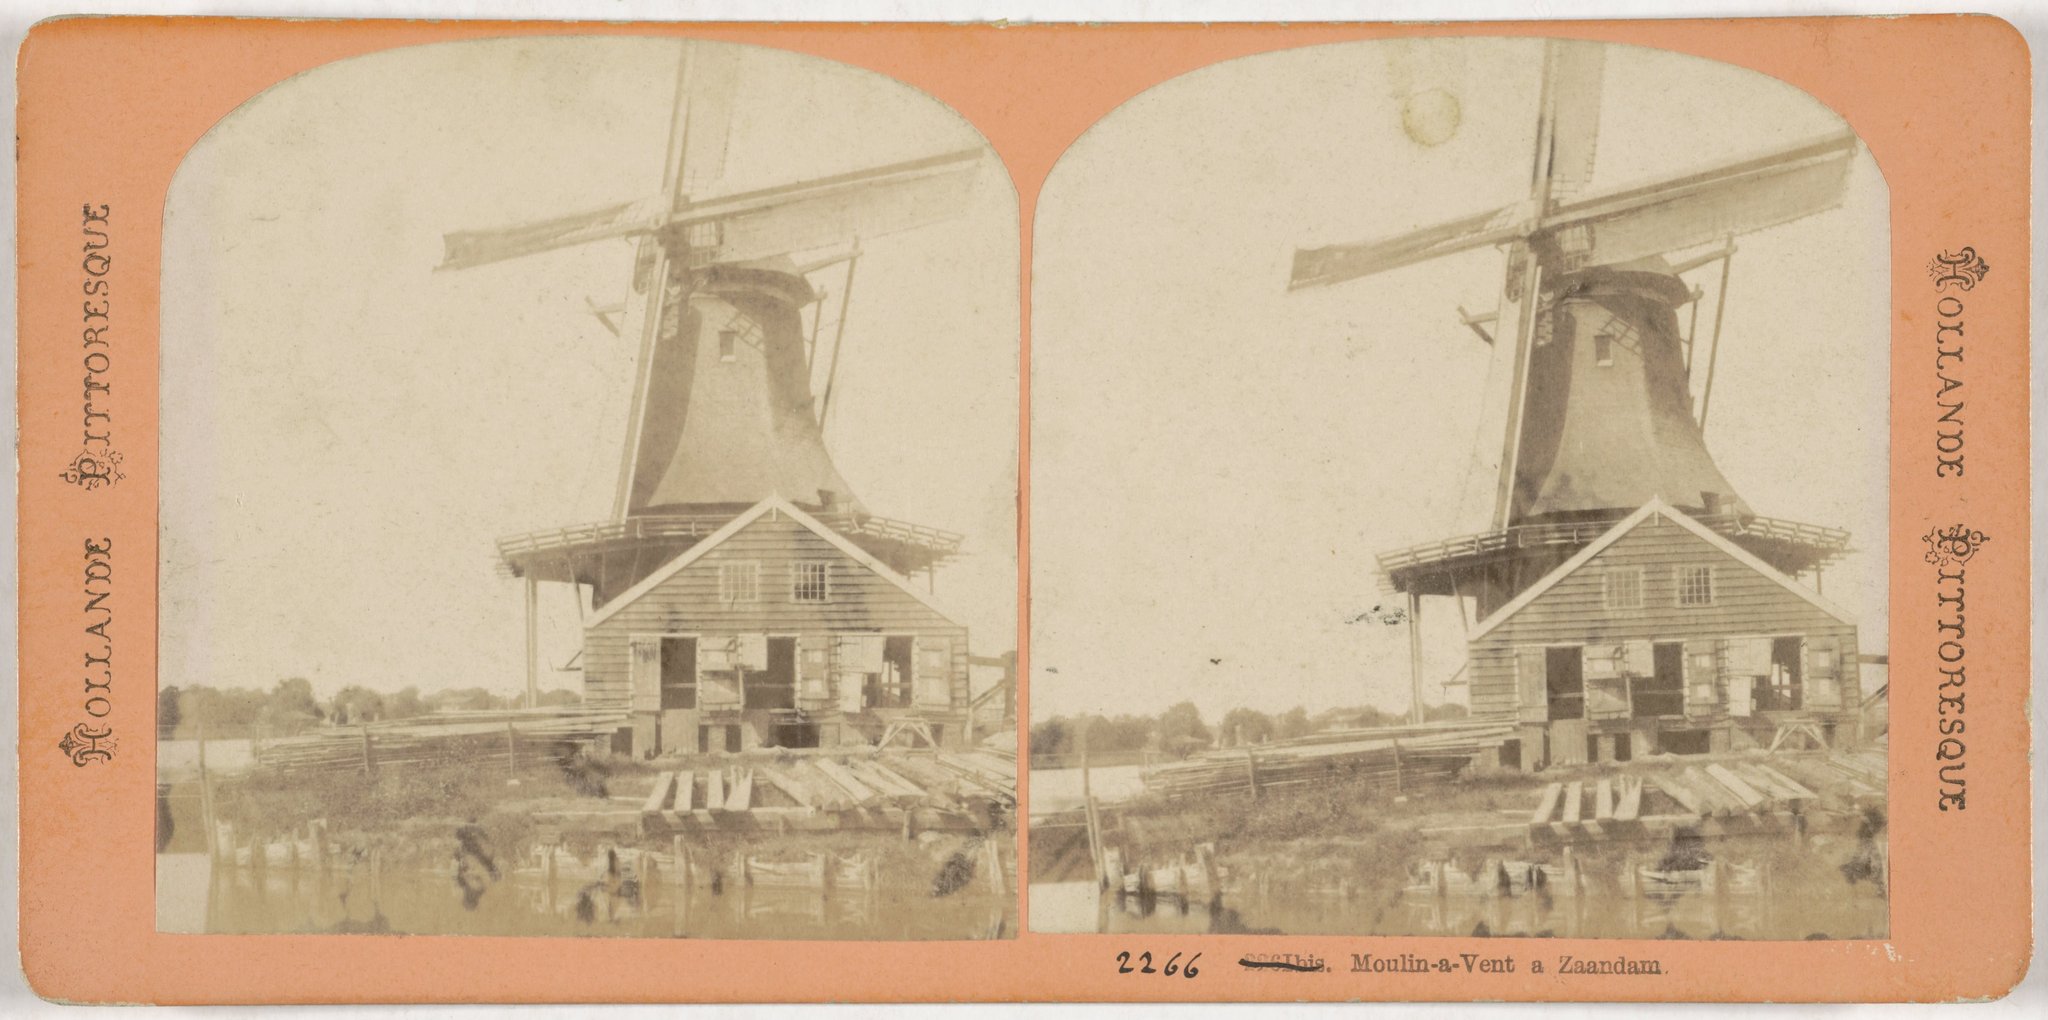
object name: stereograph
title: Moulin-a-vent a Zaandam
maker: Anonymous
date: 1873-1890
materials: cardboard, paper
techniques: albumen print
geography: zaandam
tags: windmill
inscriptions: inscription: ‘40’, number: ‘2266’, inscription: ‘296Ibis.’